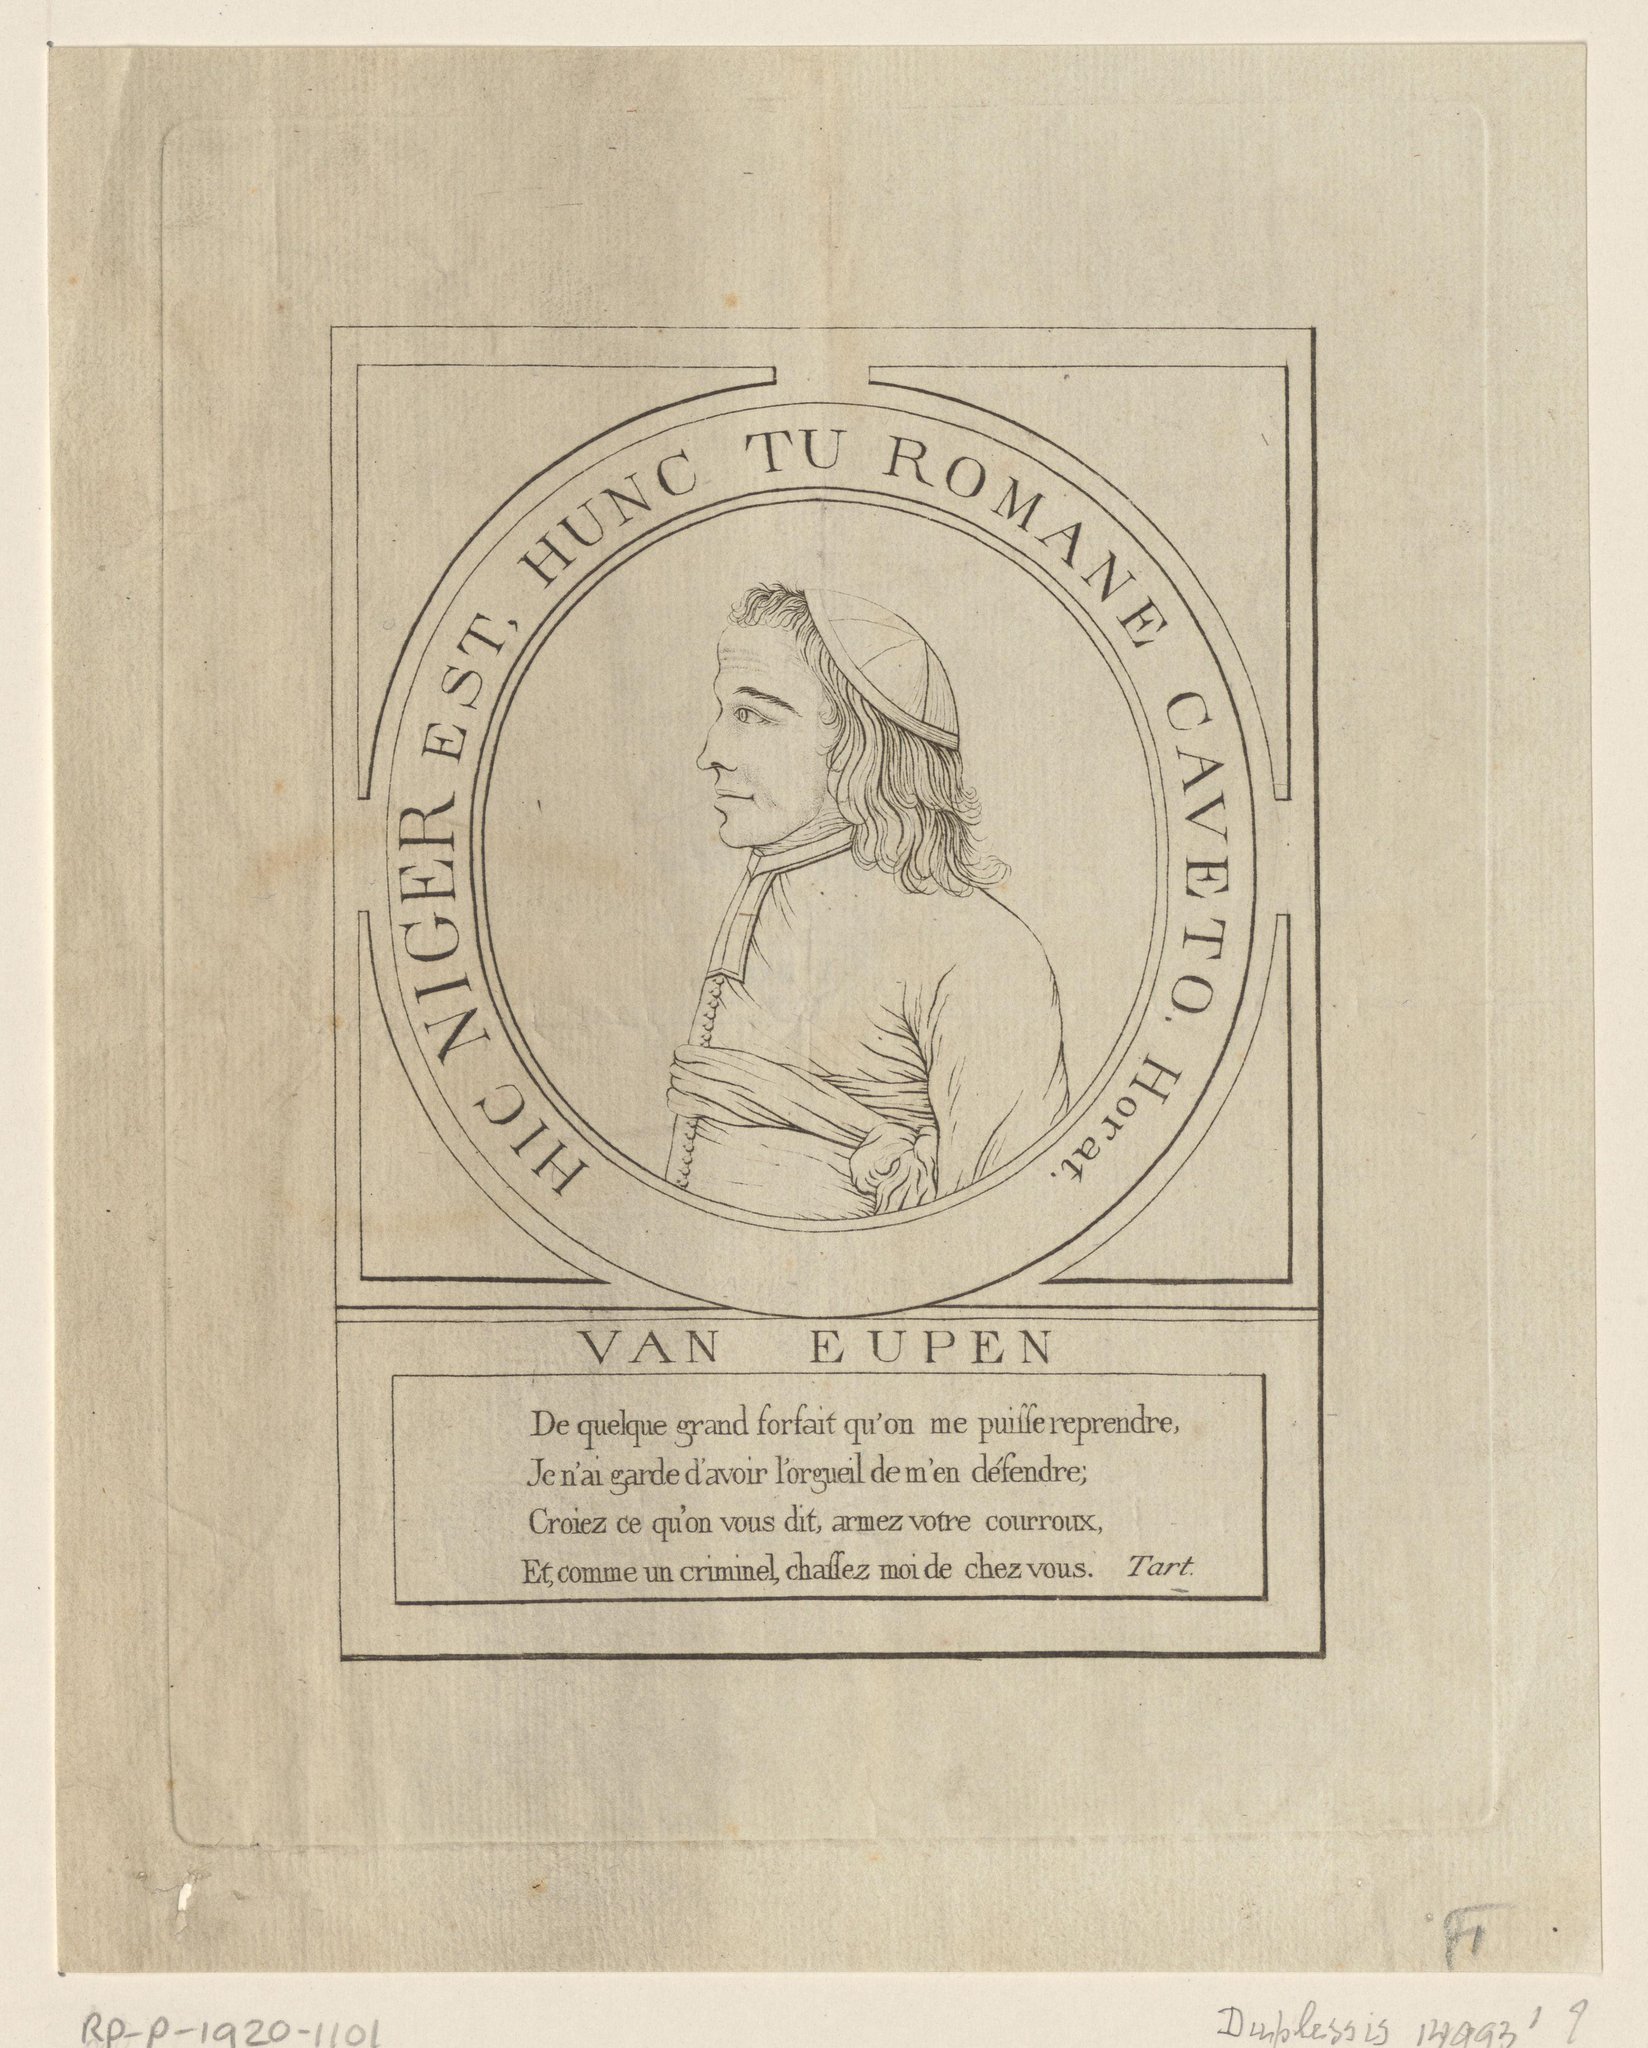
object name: print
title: Portret van Petrus Johannes Simon van Eupen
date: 1790-1850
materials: paper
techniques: etching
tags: antwerp, historical persons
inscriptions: collector's mark: Lugt 2228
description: Met vierregelig vers in het Frans uit Molières 'Tartuffe' onder het portret.